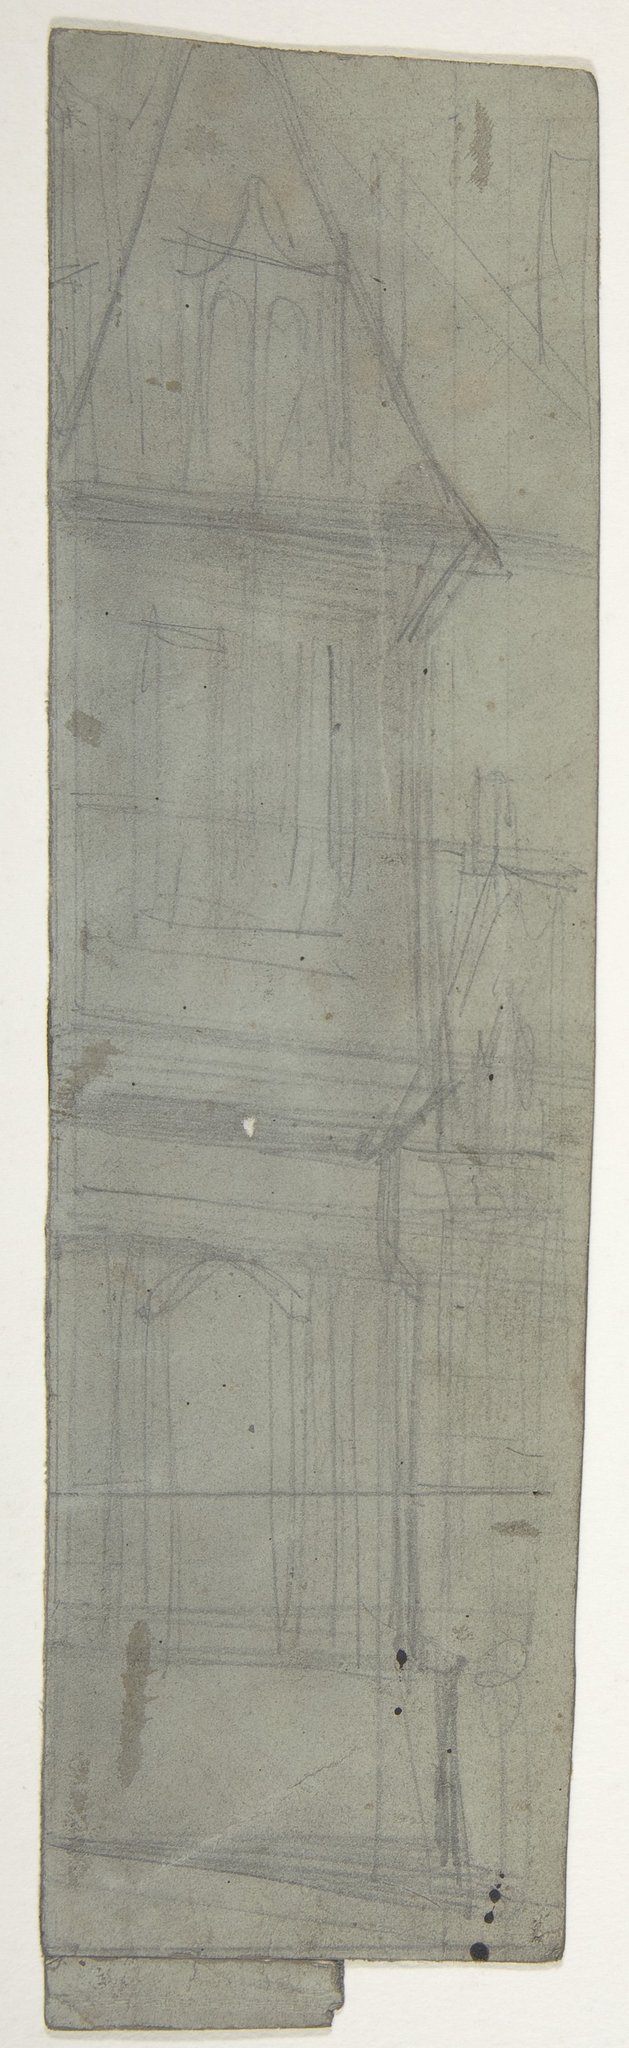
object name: drawing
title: Design for a Stage Set at the Opéra, Paris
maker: eugène cicéri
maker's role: artist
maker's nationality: french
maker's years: 1813-1890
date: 1830-1890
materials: graphite, paper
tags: buildings,stage design